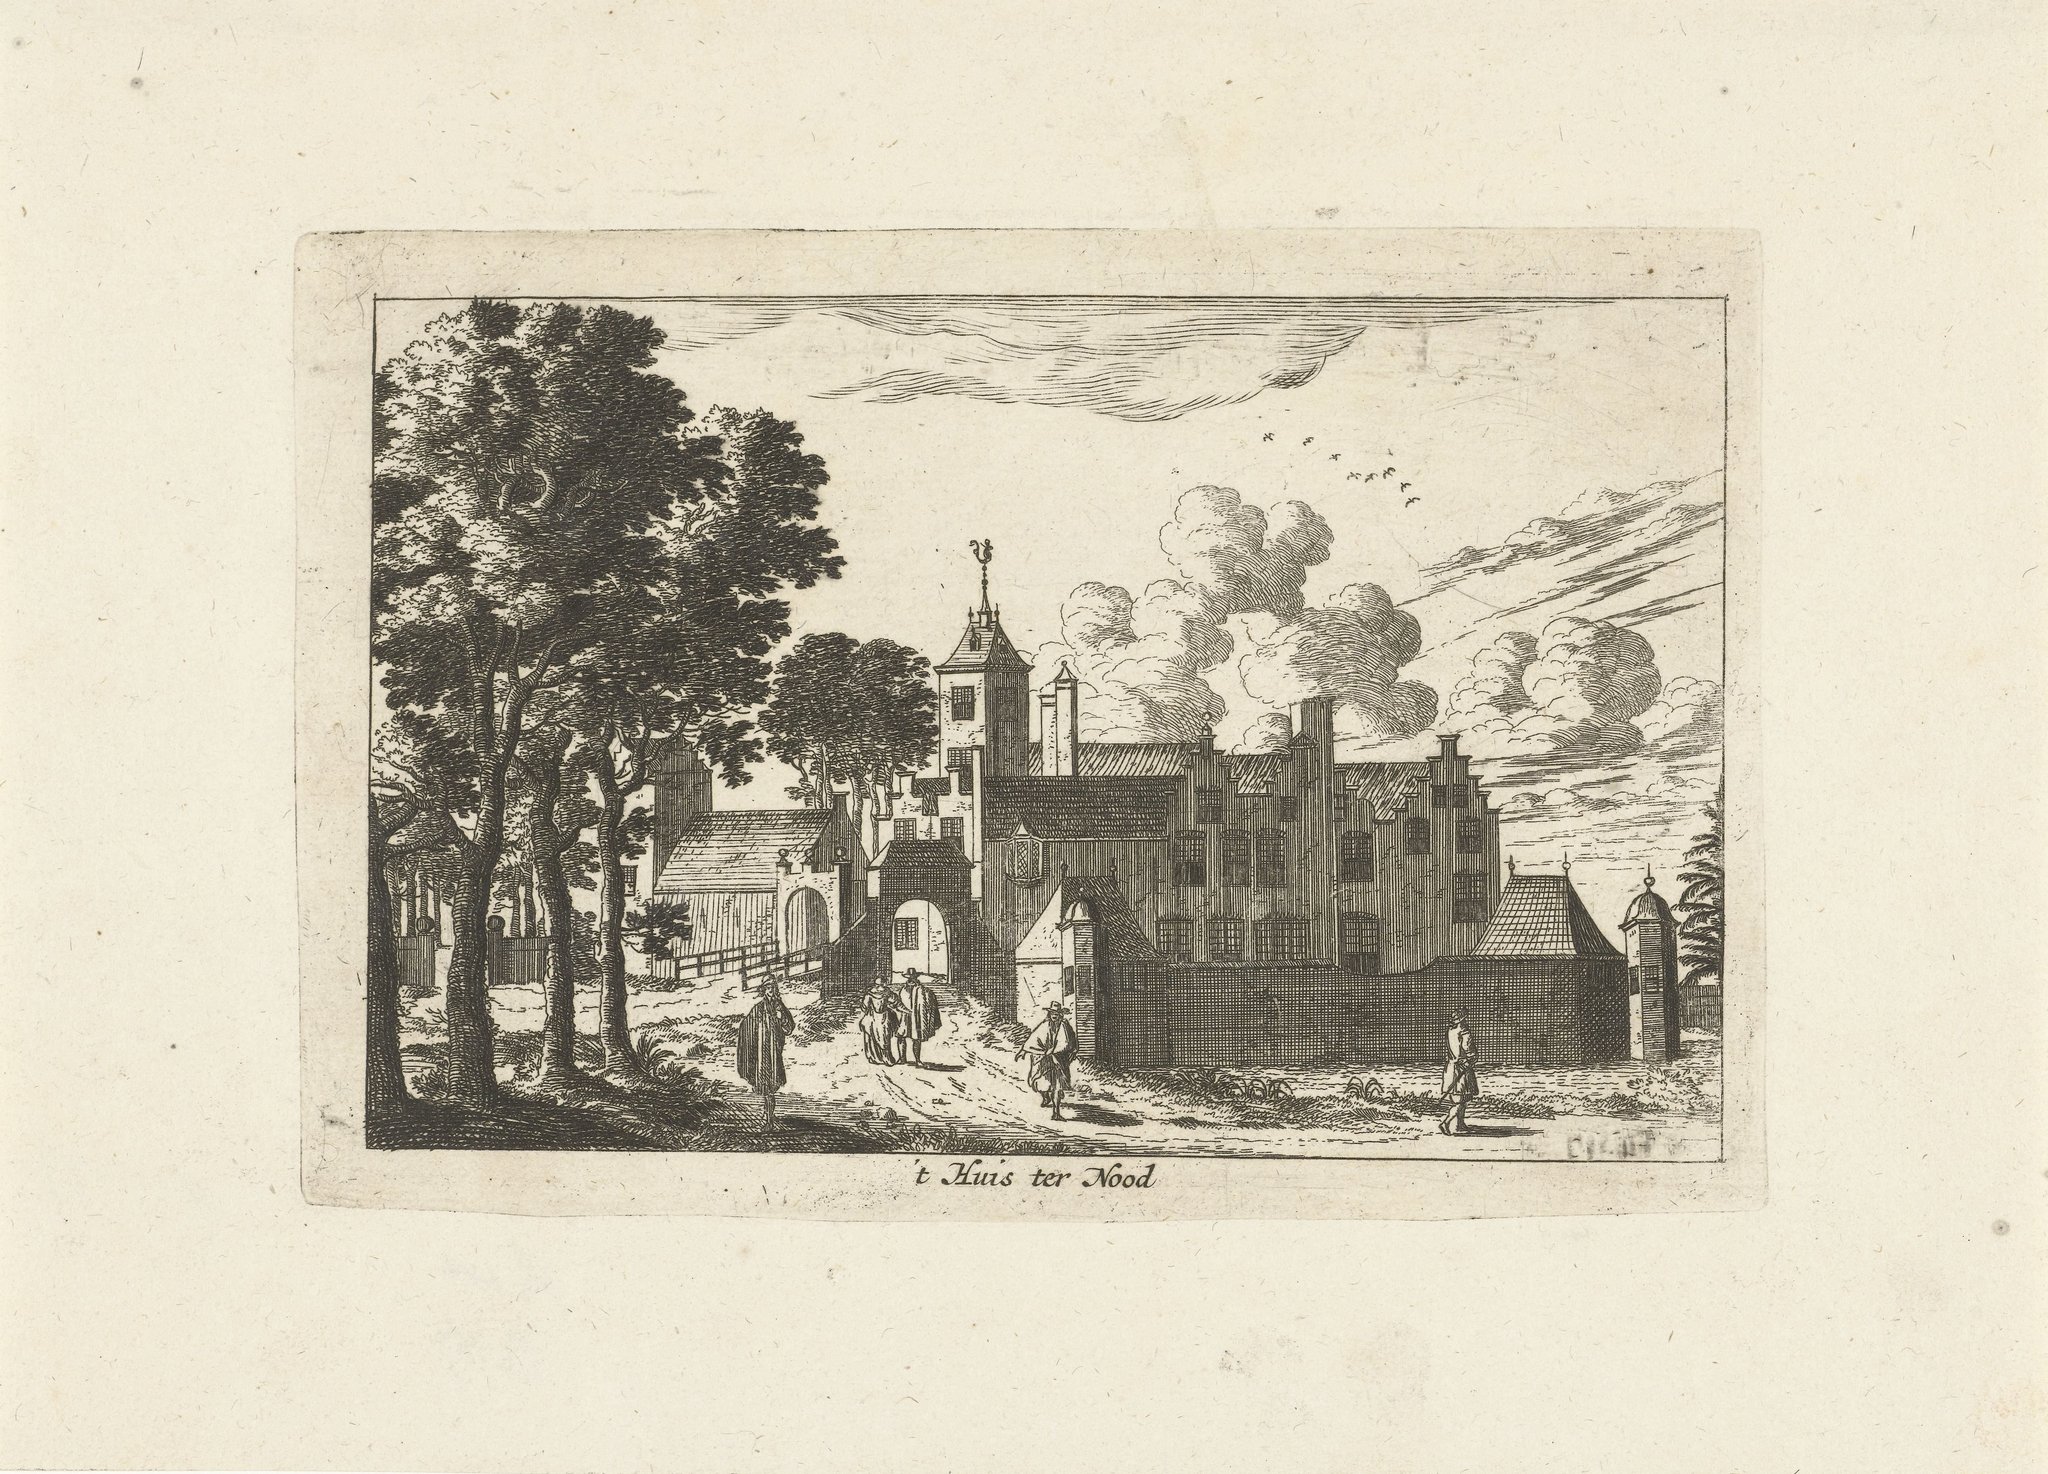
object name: print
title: 't Huis ter Nood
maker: cornelis elandts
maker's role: draughtsman, painter, print maker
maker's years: 1641-1687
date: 1663-1670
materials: paper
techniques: engraving, etching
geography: the hague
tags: castle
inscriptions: collector's mark: Lugt 2228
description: Gezicht op kasteel Ter Noot, gebouwd in 1596, in de omgeving van het huidige Bezuidenhout te Den Haag. Op de voorgrond een boompartij en vijf personen op een pad wat naar de toegangspoort van het kasteel leidt.